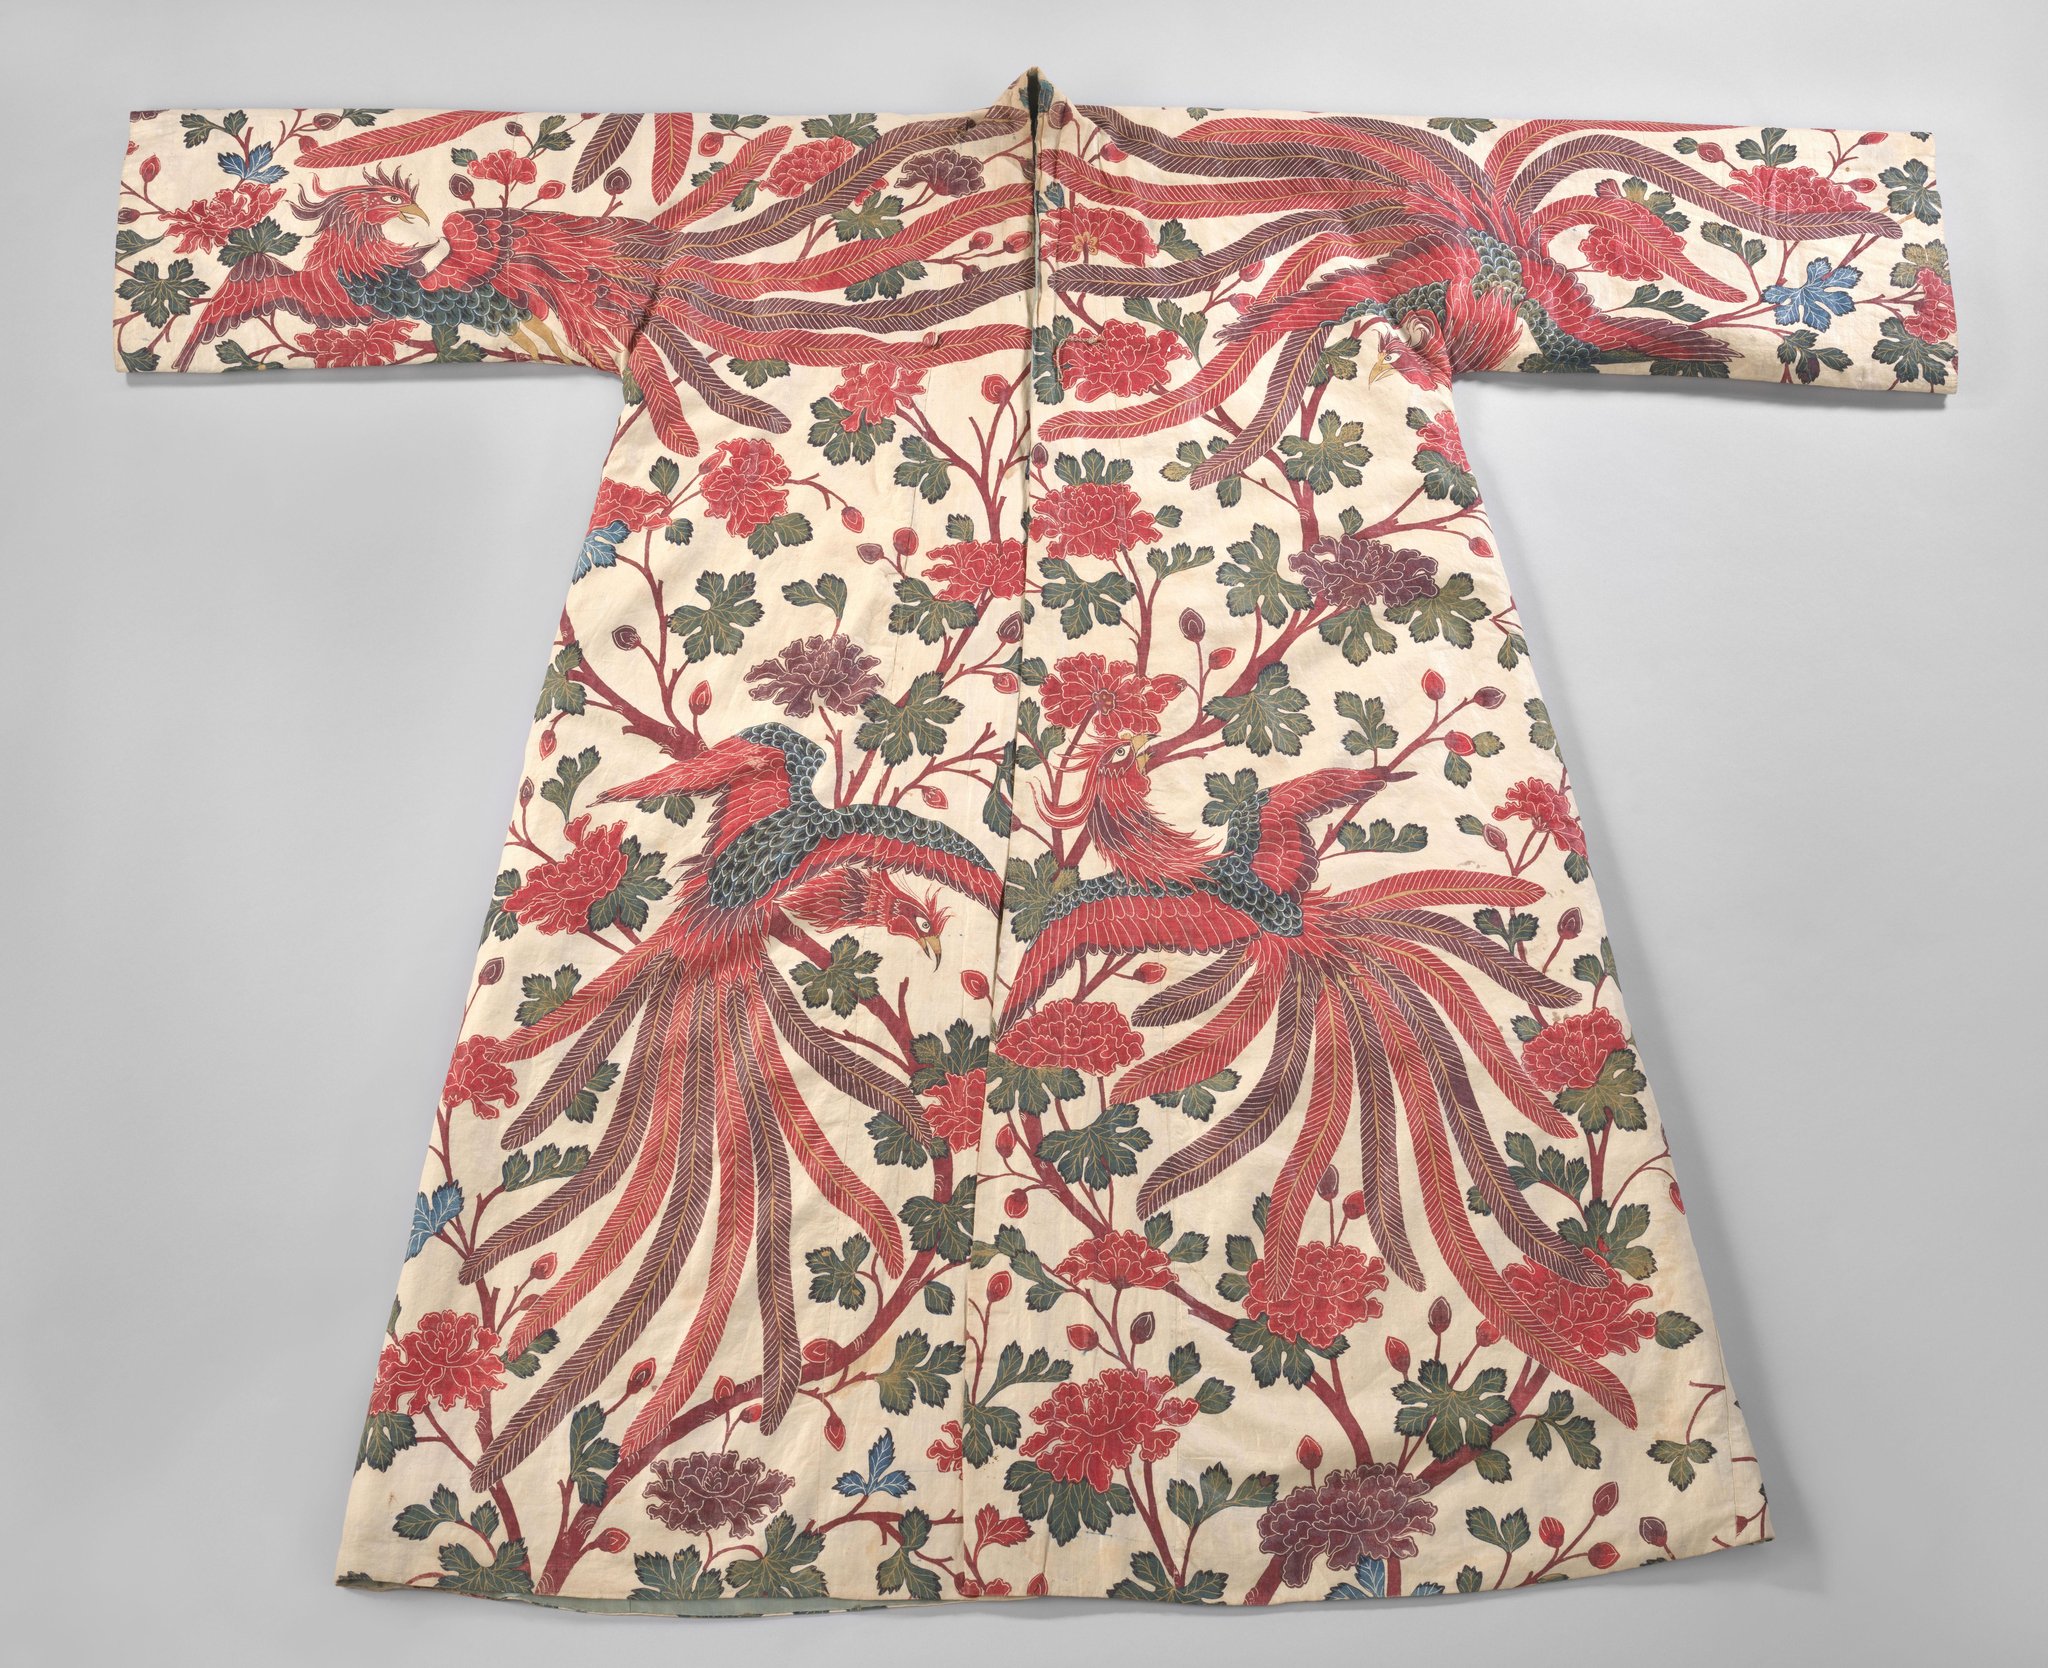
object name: skirt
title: House Coat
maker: Anonymous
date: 1740-1750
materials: textile, cotton, silk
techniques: weave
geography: coromandel coast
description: House coats based on the Japanese kimono and the Indian Cambay were extremely popular in the Netherlands in the 17th and 18th century. This one is made of chintz, a fabric for which India was famous. However, the motifs are Chinese. The large birds extending over the entire coat in fluent movements are fenghuangs, Chinese mythical creatures. The flowers are Chinese peonies.